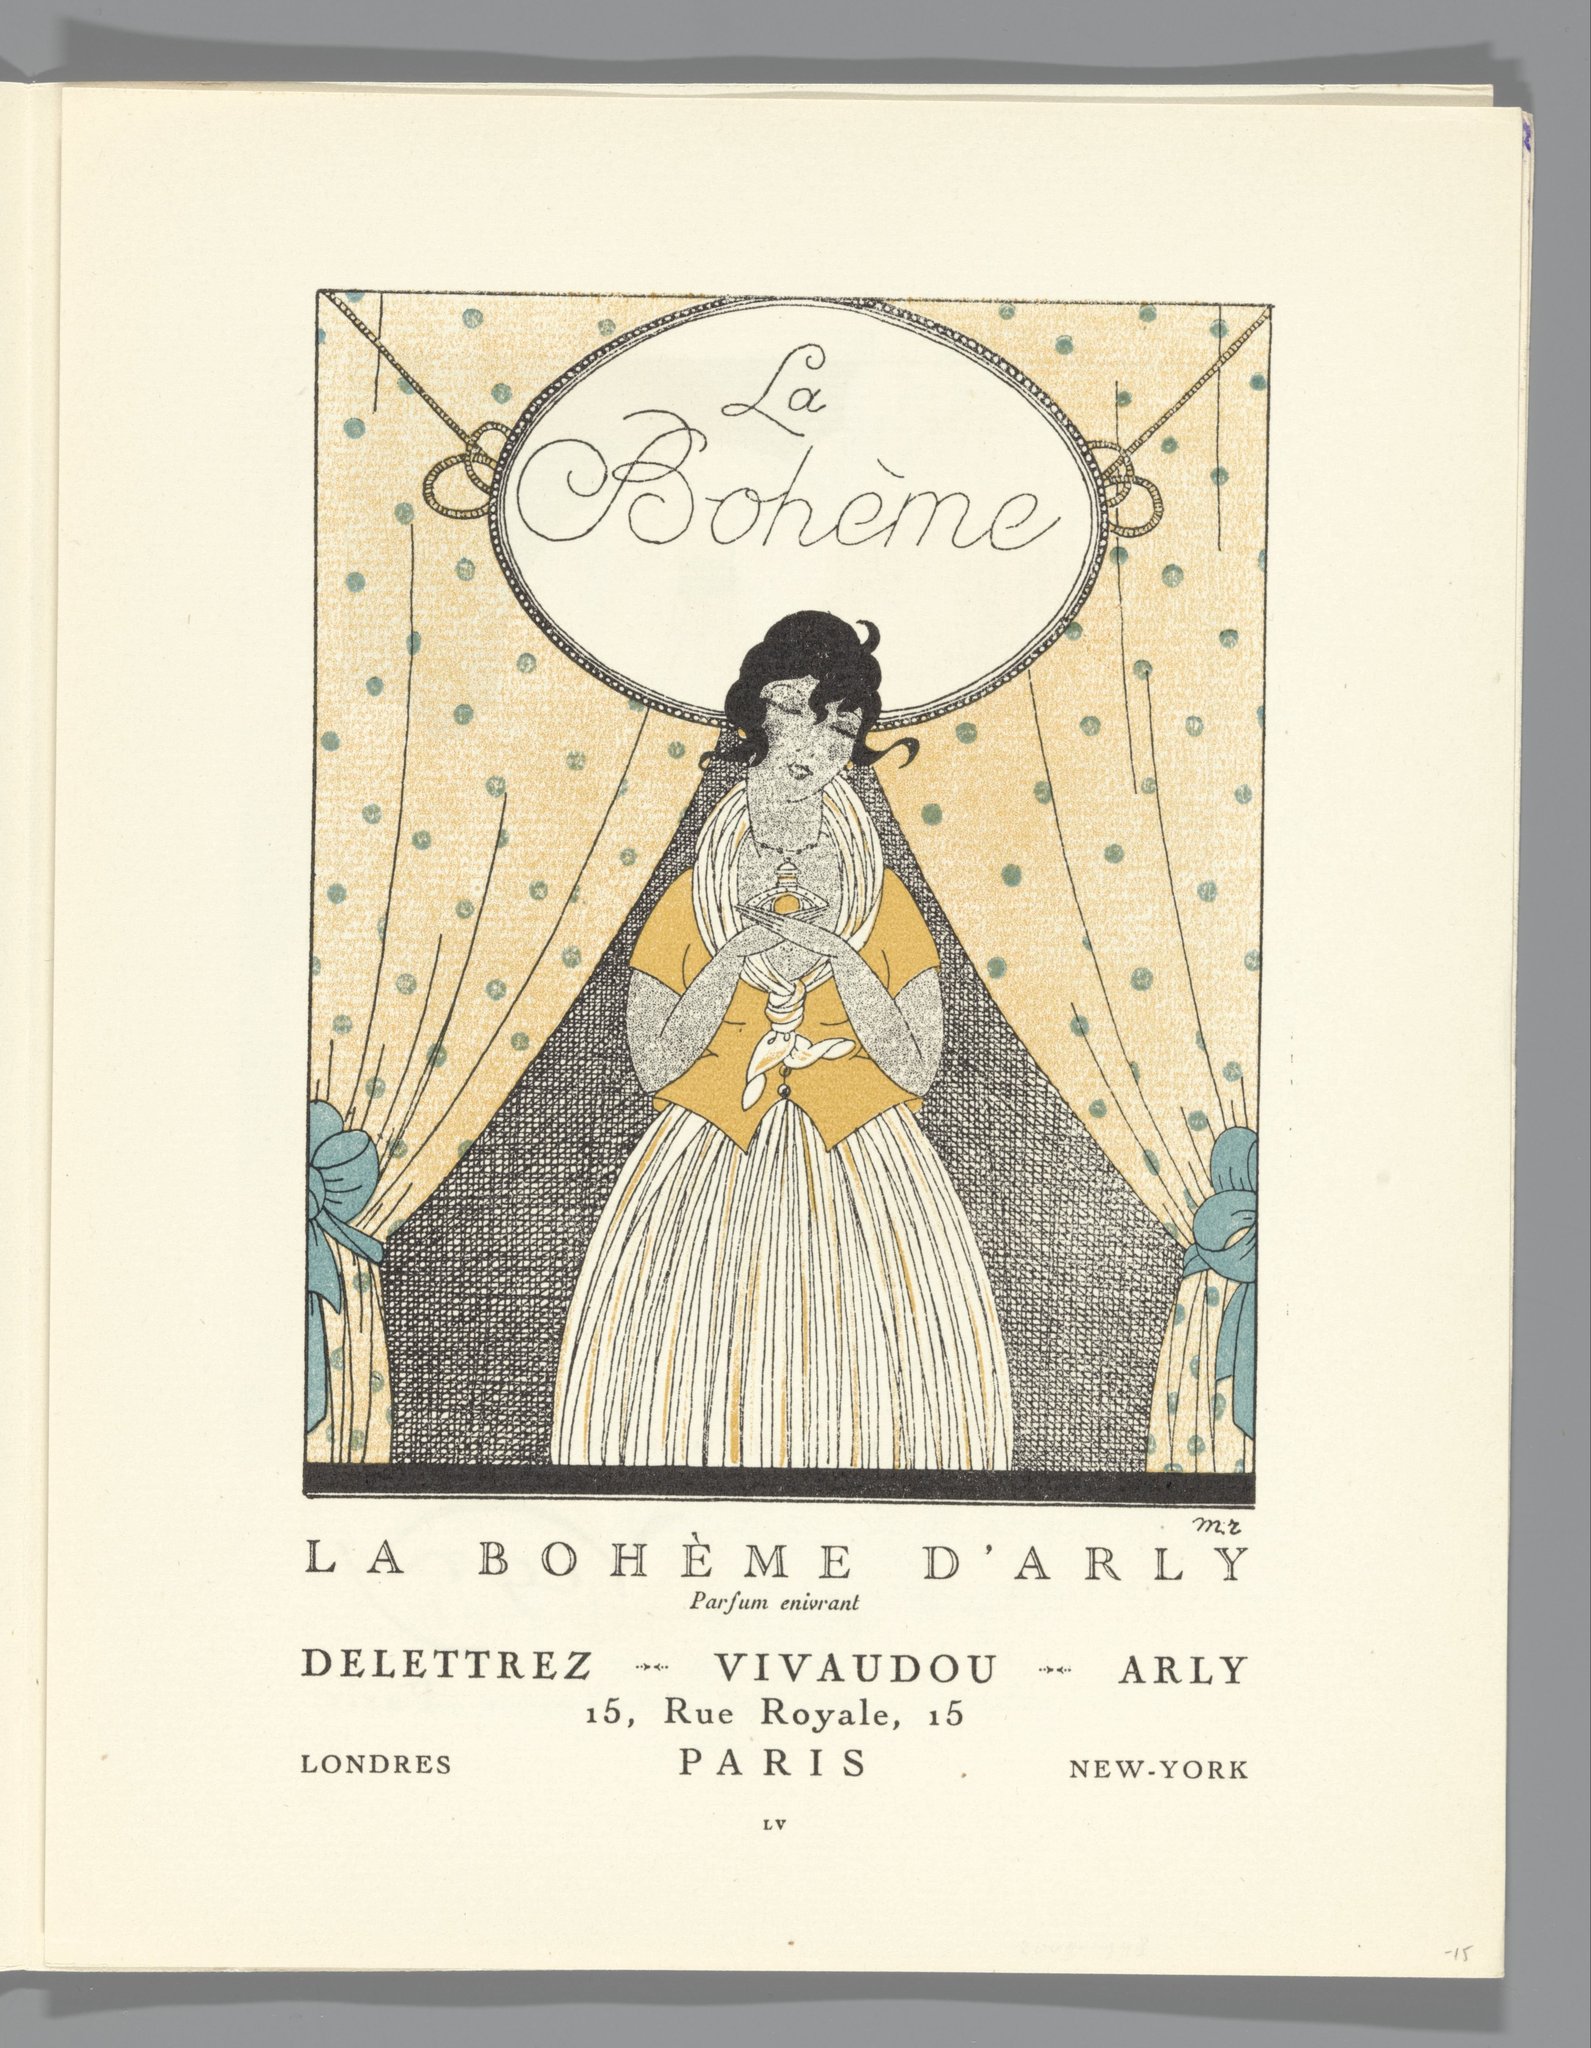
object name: fashion print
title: Gazette du Bon Ton. Art – Modes & Frivolités: Advertising Material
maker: lucien vogel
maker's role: publisher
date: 1920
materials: paper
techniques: lithograph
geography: paris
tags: perfume bottle - aa - (for) women, fashion plates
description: The Gazette du Bon Ton also included advertisements: for shops selling fashions and fabrics, jewellers, hairdressers and beauticians. These ads were also well designed; many were drawn by the same artists who supplied the fashion plates. Even the smallest ads were presented with flair and in a style that was befitting of the whole.